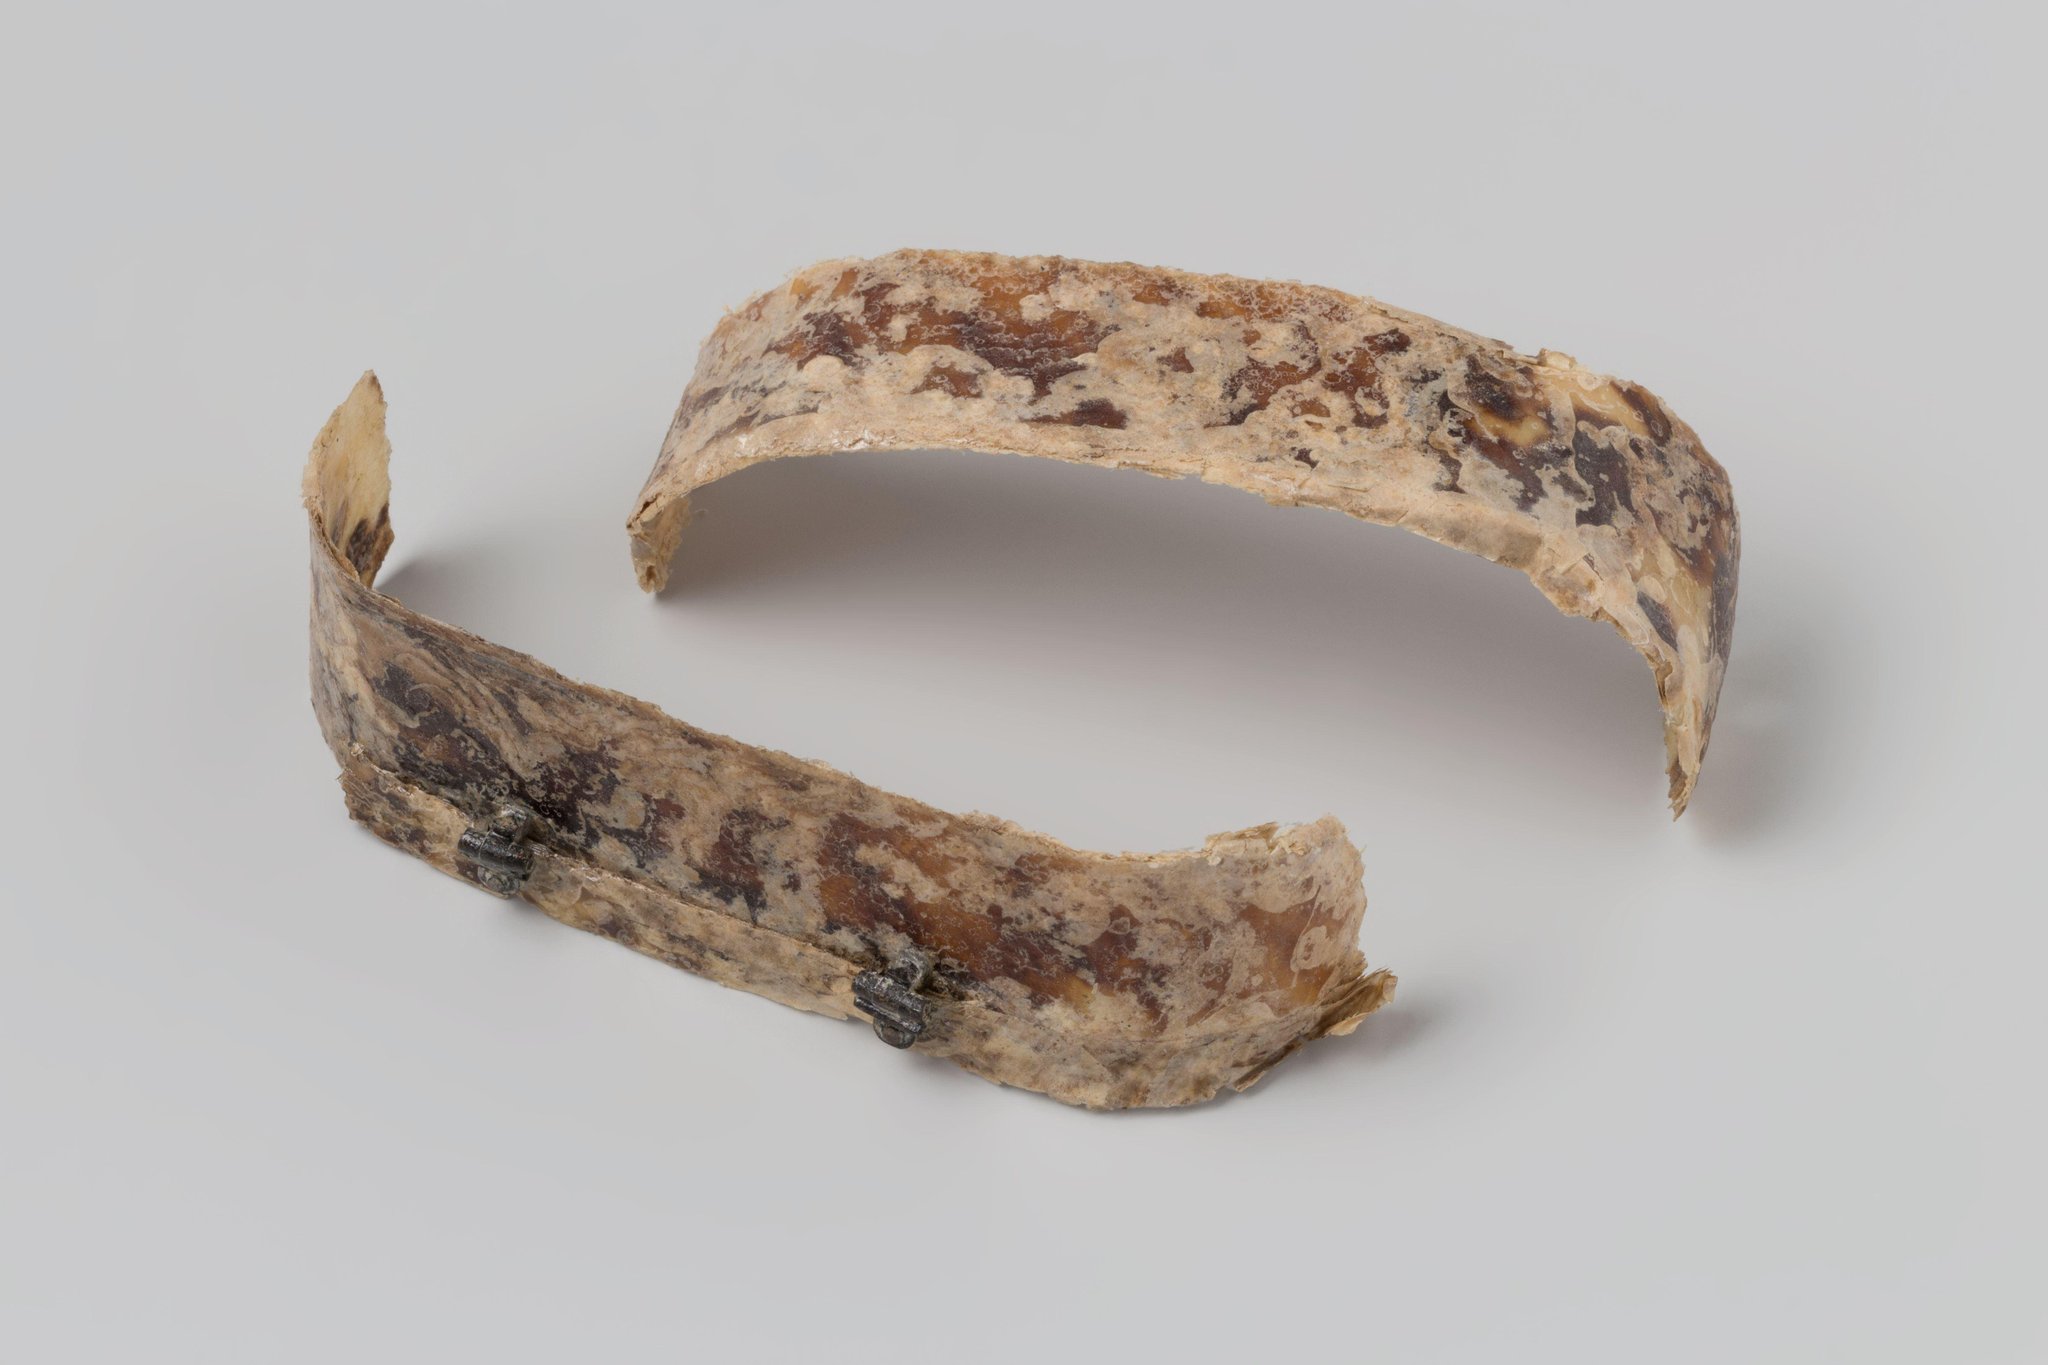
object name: snuffbox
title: Side of a horn or turtle shell snuff box from the wreck of the Dutch East India ship 't Vliegend Hart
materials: copper, horn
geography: middelburg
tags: 't vliegend hart (schip), verenigde oostindische compagnie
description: Hoornen zijkant van een snuifdoos met krullend koperen deel van een scharnier. Hoort bij een soortgelijke zijkant met hetzelfde vondstnummer maar dan zonder scharnier.